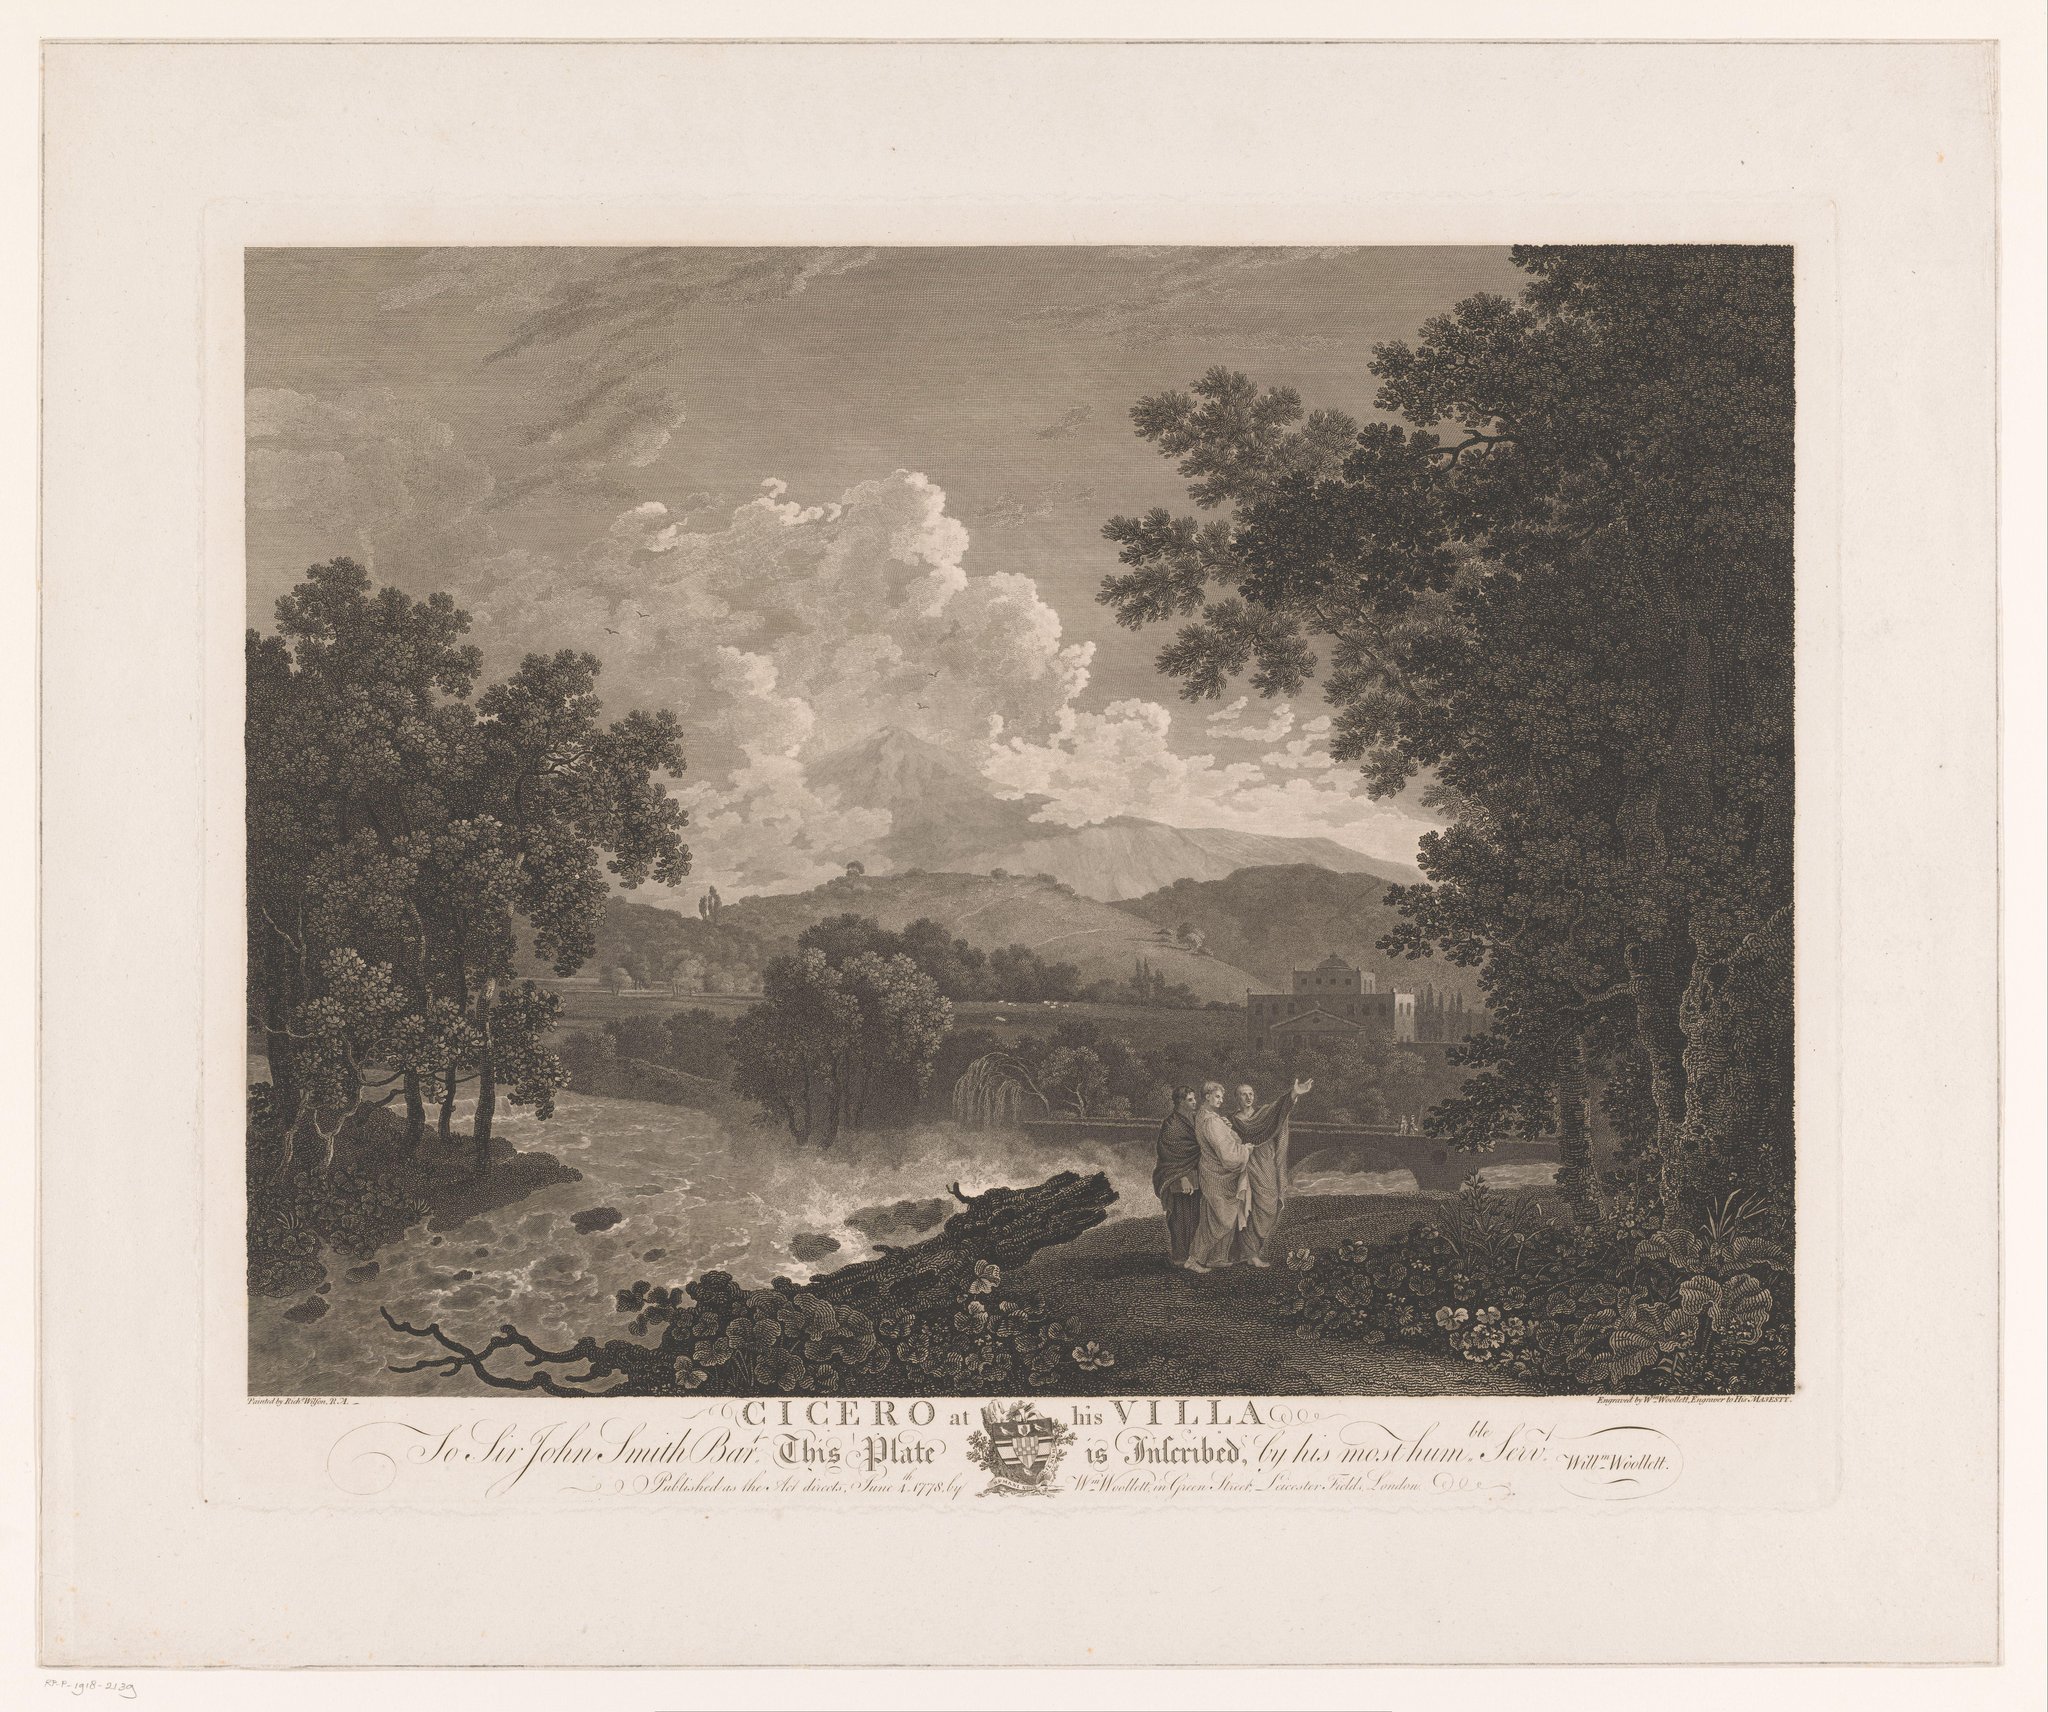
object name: print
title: Cicero at his Villa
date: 1706-1778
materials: paper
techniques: etching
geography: london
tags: marcus tullius cicero, (story of) cicero, river, villa, landscape with bridge, viaduct or aqueduct (+ city(-scape) with figures, staffage), mountains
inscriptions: collector's mark: Lugt 2233